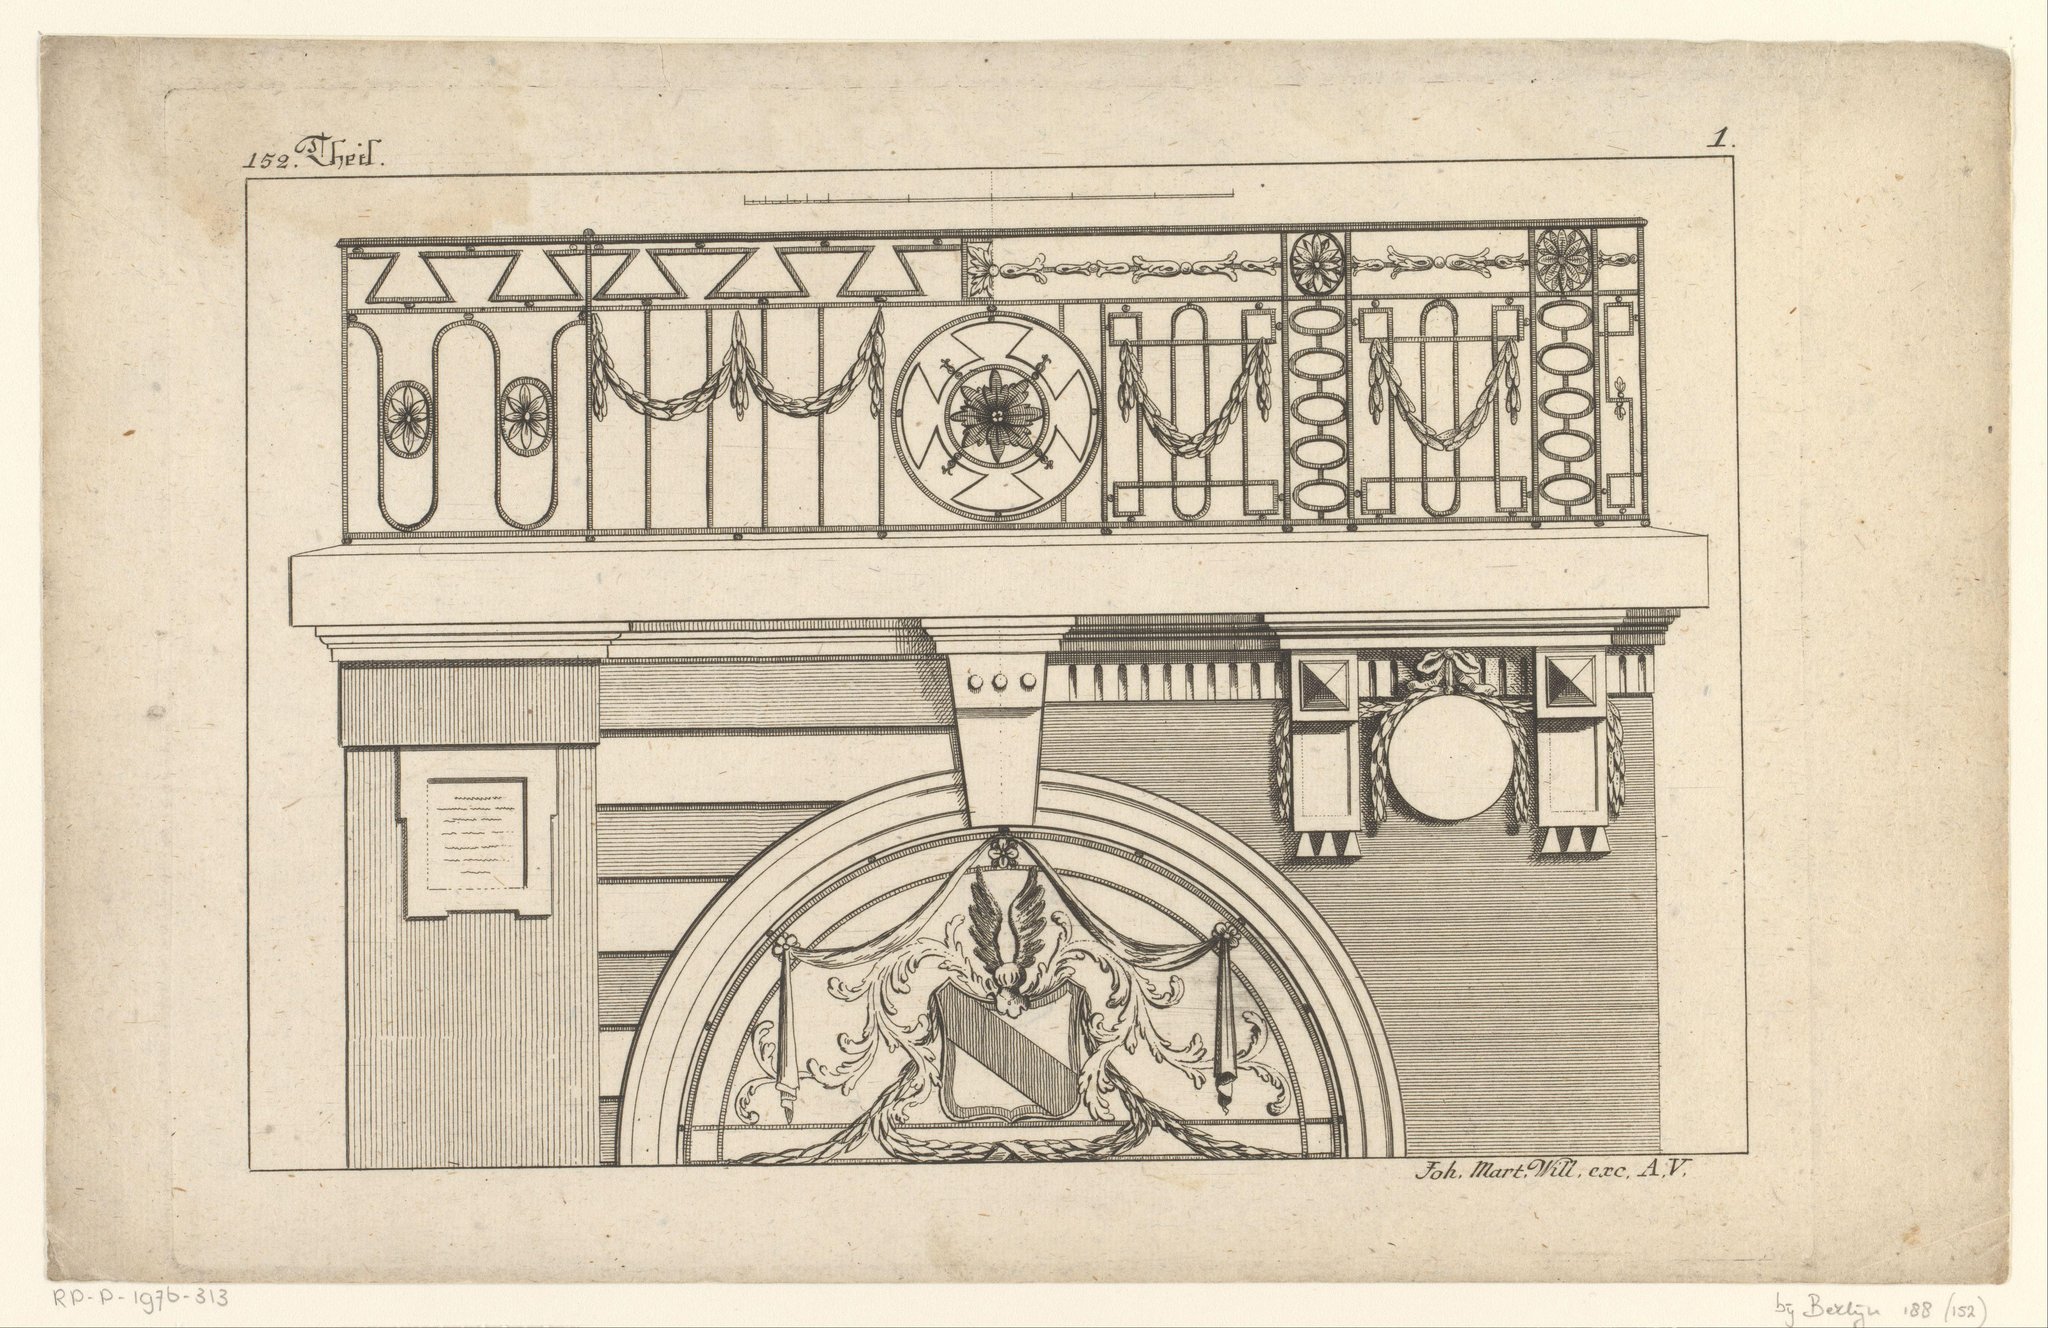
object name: print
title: Balustrade boven een ingangspartij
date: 1737-1806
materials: paper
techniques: etching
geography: augsburg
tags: coat of arms (symbol of sovereignty), welding (industrial process), ornament ~ medallion, balustrade, ornament ~ festoon, garland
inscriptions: collector's mark: Lugt 2228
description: Een smeedijzeren balustrade met bloemmotieven en guirlandes boven een ingangspartij met bladmotieven, een medaillon en een wapenschild.